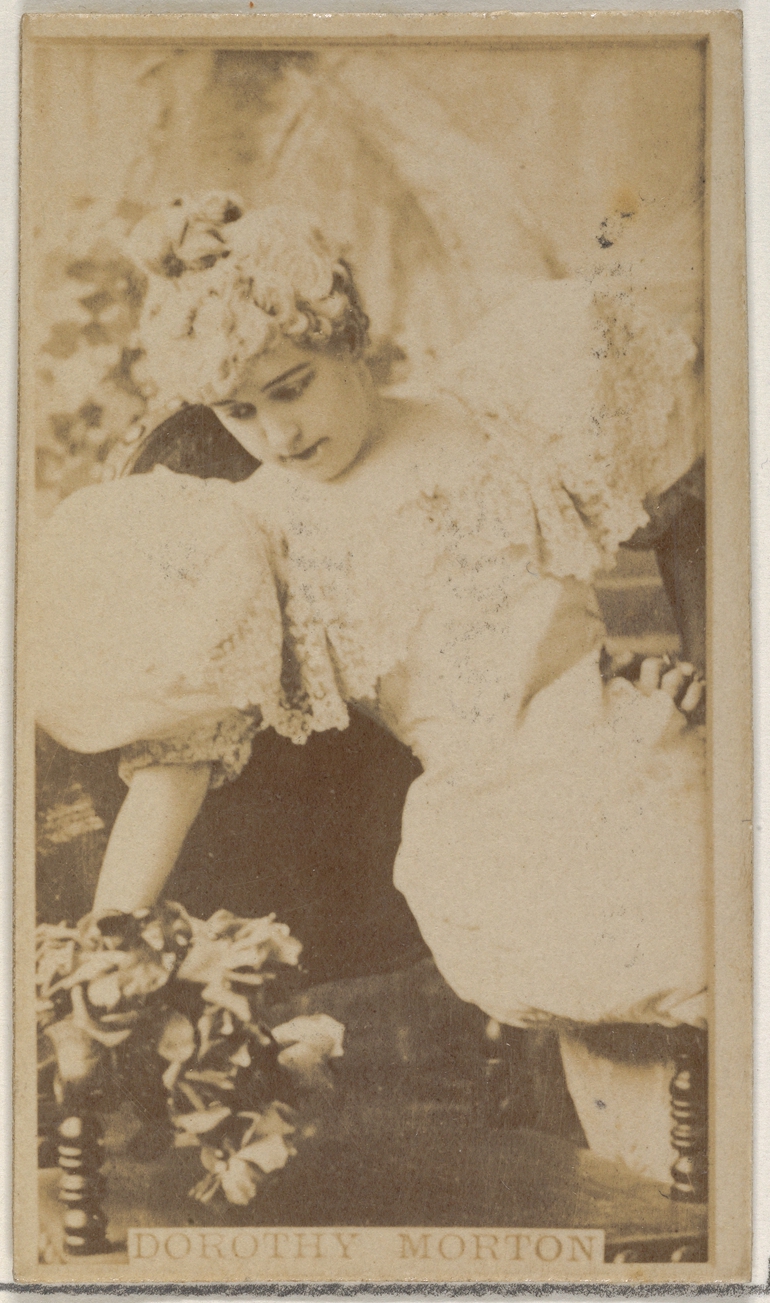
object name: photograph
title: Dorothy Morton, from the Actors and Actresses series (N45, Type 8) for Virginia Brights Cigarettes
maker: allen & ginter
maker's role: publisher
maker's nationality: american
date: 1888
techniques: albumen silver print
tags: portraits,women,actresses